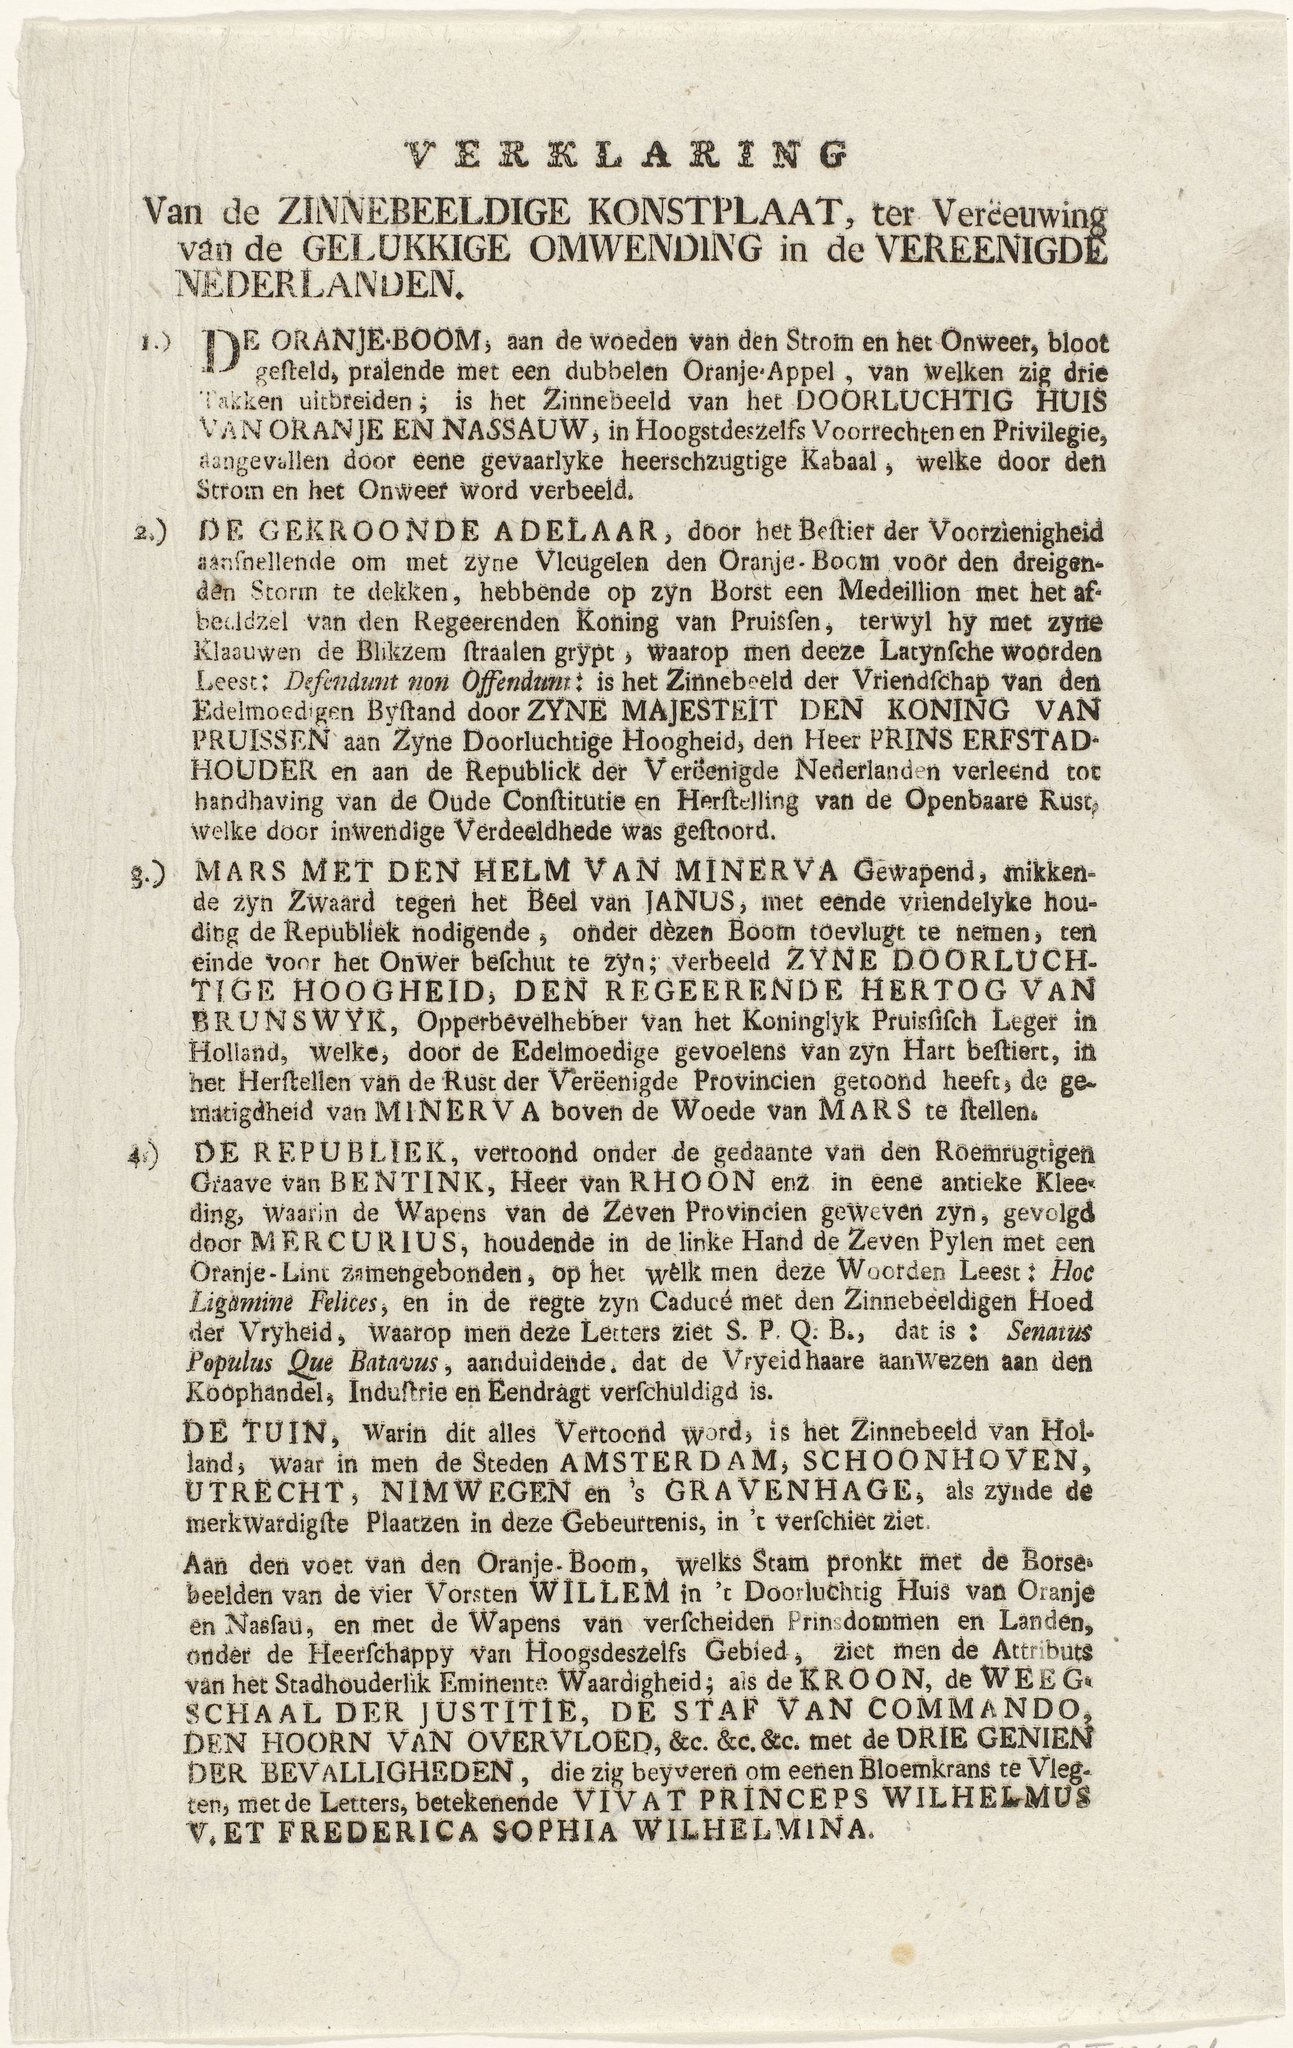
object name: text sheet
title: Verklaring bij de Allegorie op het herstel van stadhouder Willem V, 1787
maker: Anonymous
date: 1787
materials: paper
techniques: letterpress printing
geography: northern netherlands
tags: william v (prince of orange), karel willem ferdinand hertog van brunswijk-wolfenbüttel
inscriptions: collector's mark: Lugt 2228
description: Tekstblad met een verklaring van de voorstelling van de prent met de allegorie op het herstel van stadhouder Willem V in 1787. Uitleg in vier punten.